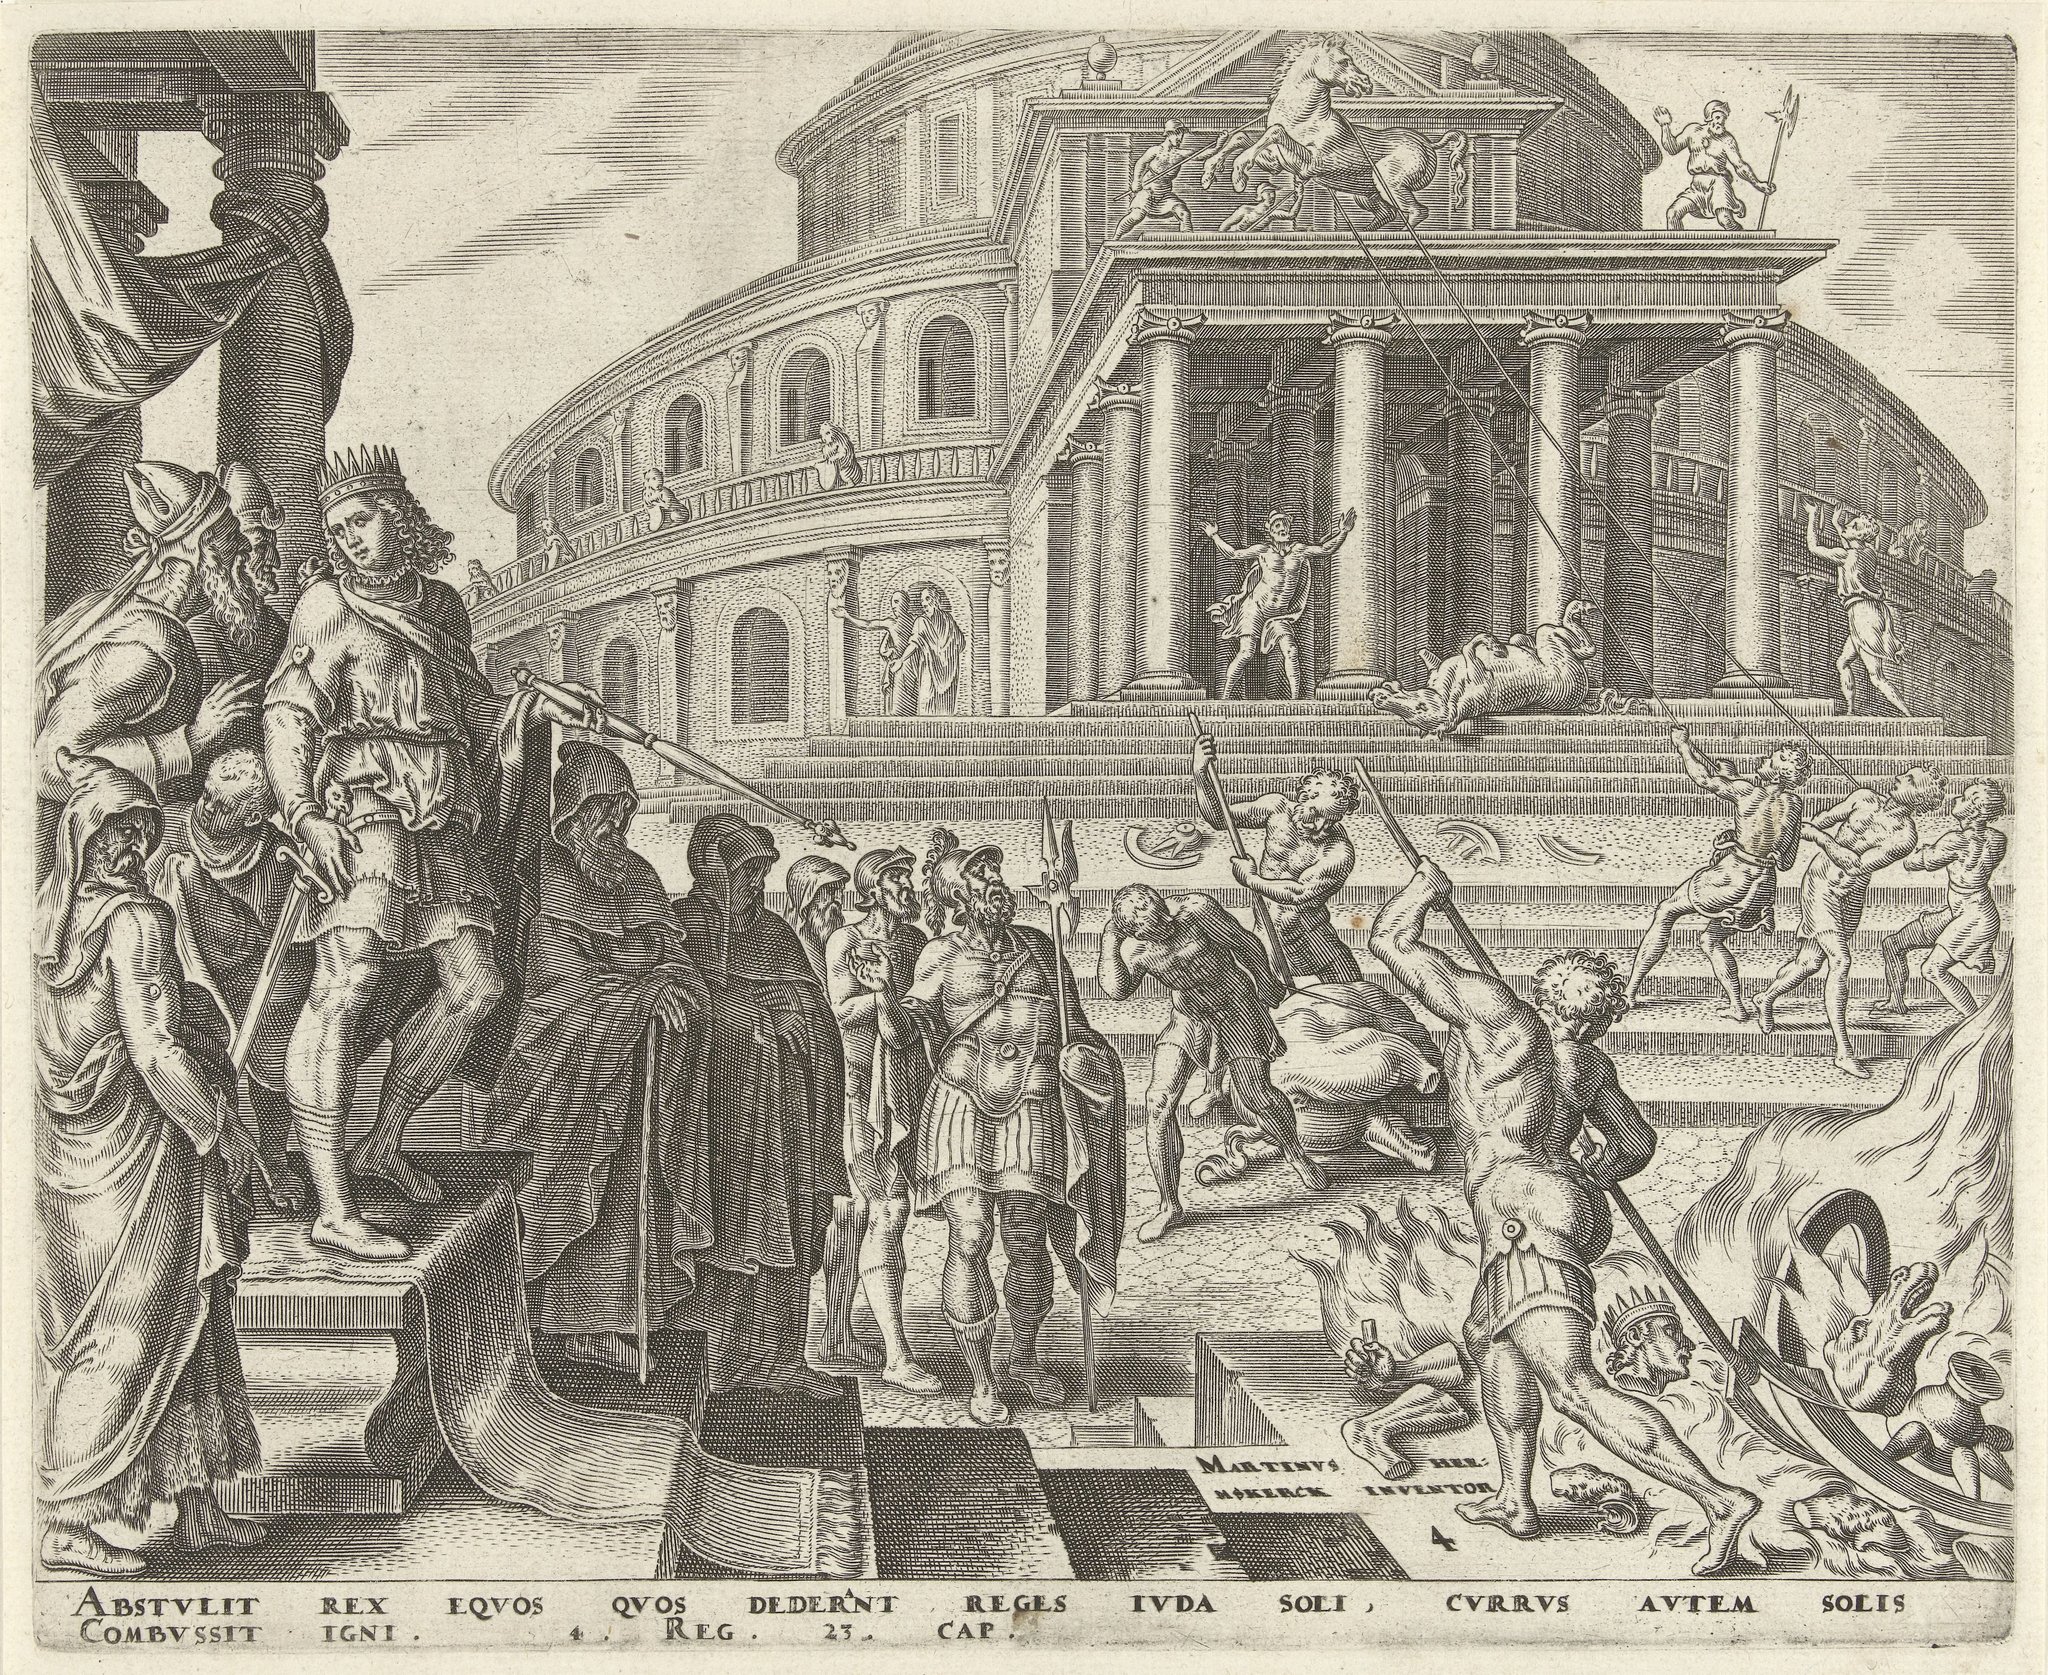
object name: print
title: Koning Josia laat de paarden en wagens ter ere van de zon verwijderen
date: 1569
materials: paper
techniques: engraving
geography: haarlem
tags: josiah removes the horses and burns the chariots used in the worship of the sun-god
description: Koning Josia staat op een trap op het plein voor de tempel en bekijkt hoe standbeelden van paarden en zonnewagens van de tempelingang worden getrokken en op het plein worden verbrand. De standbeelden waren opgericht ter ere van de zon.